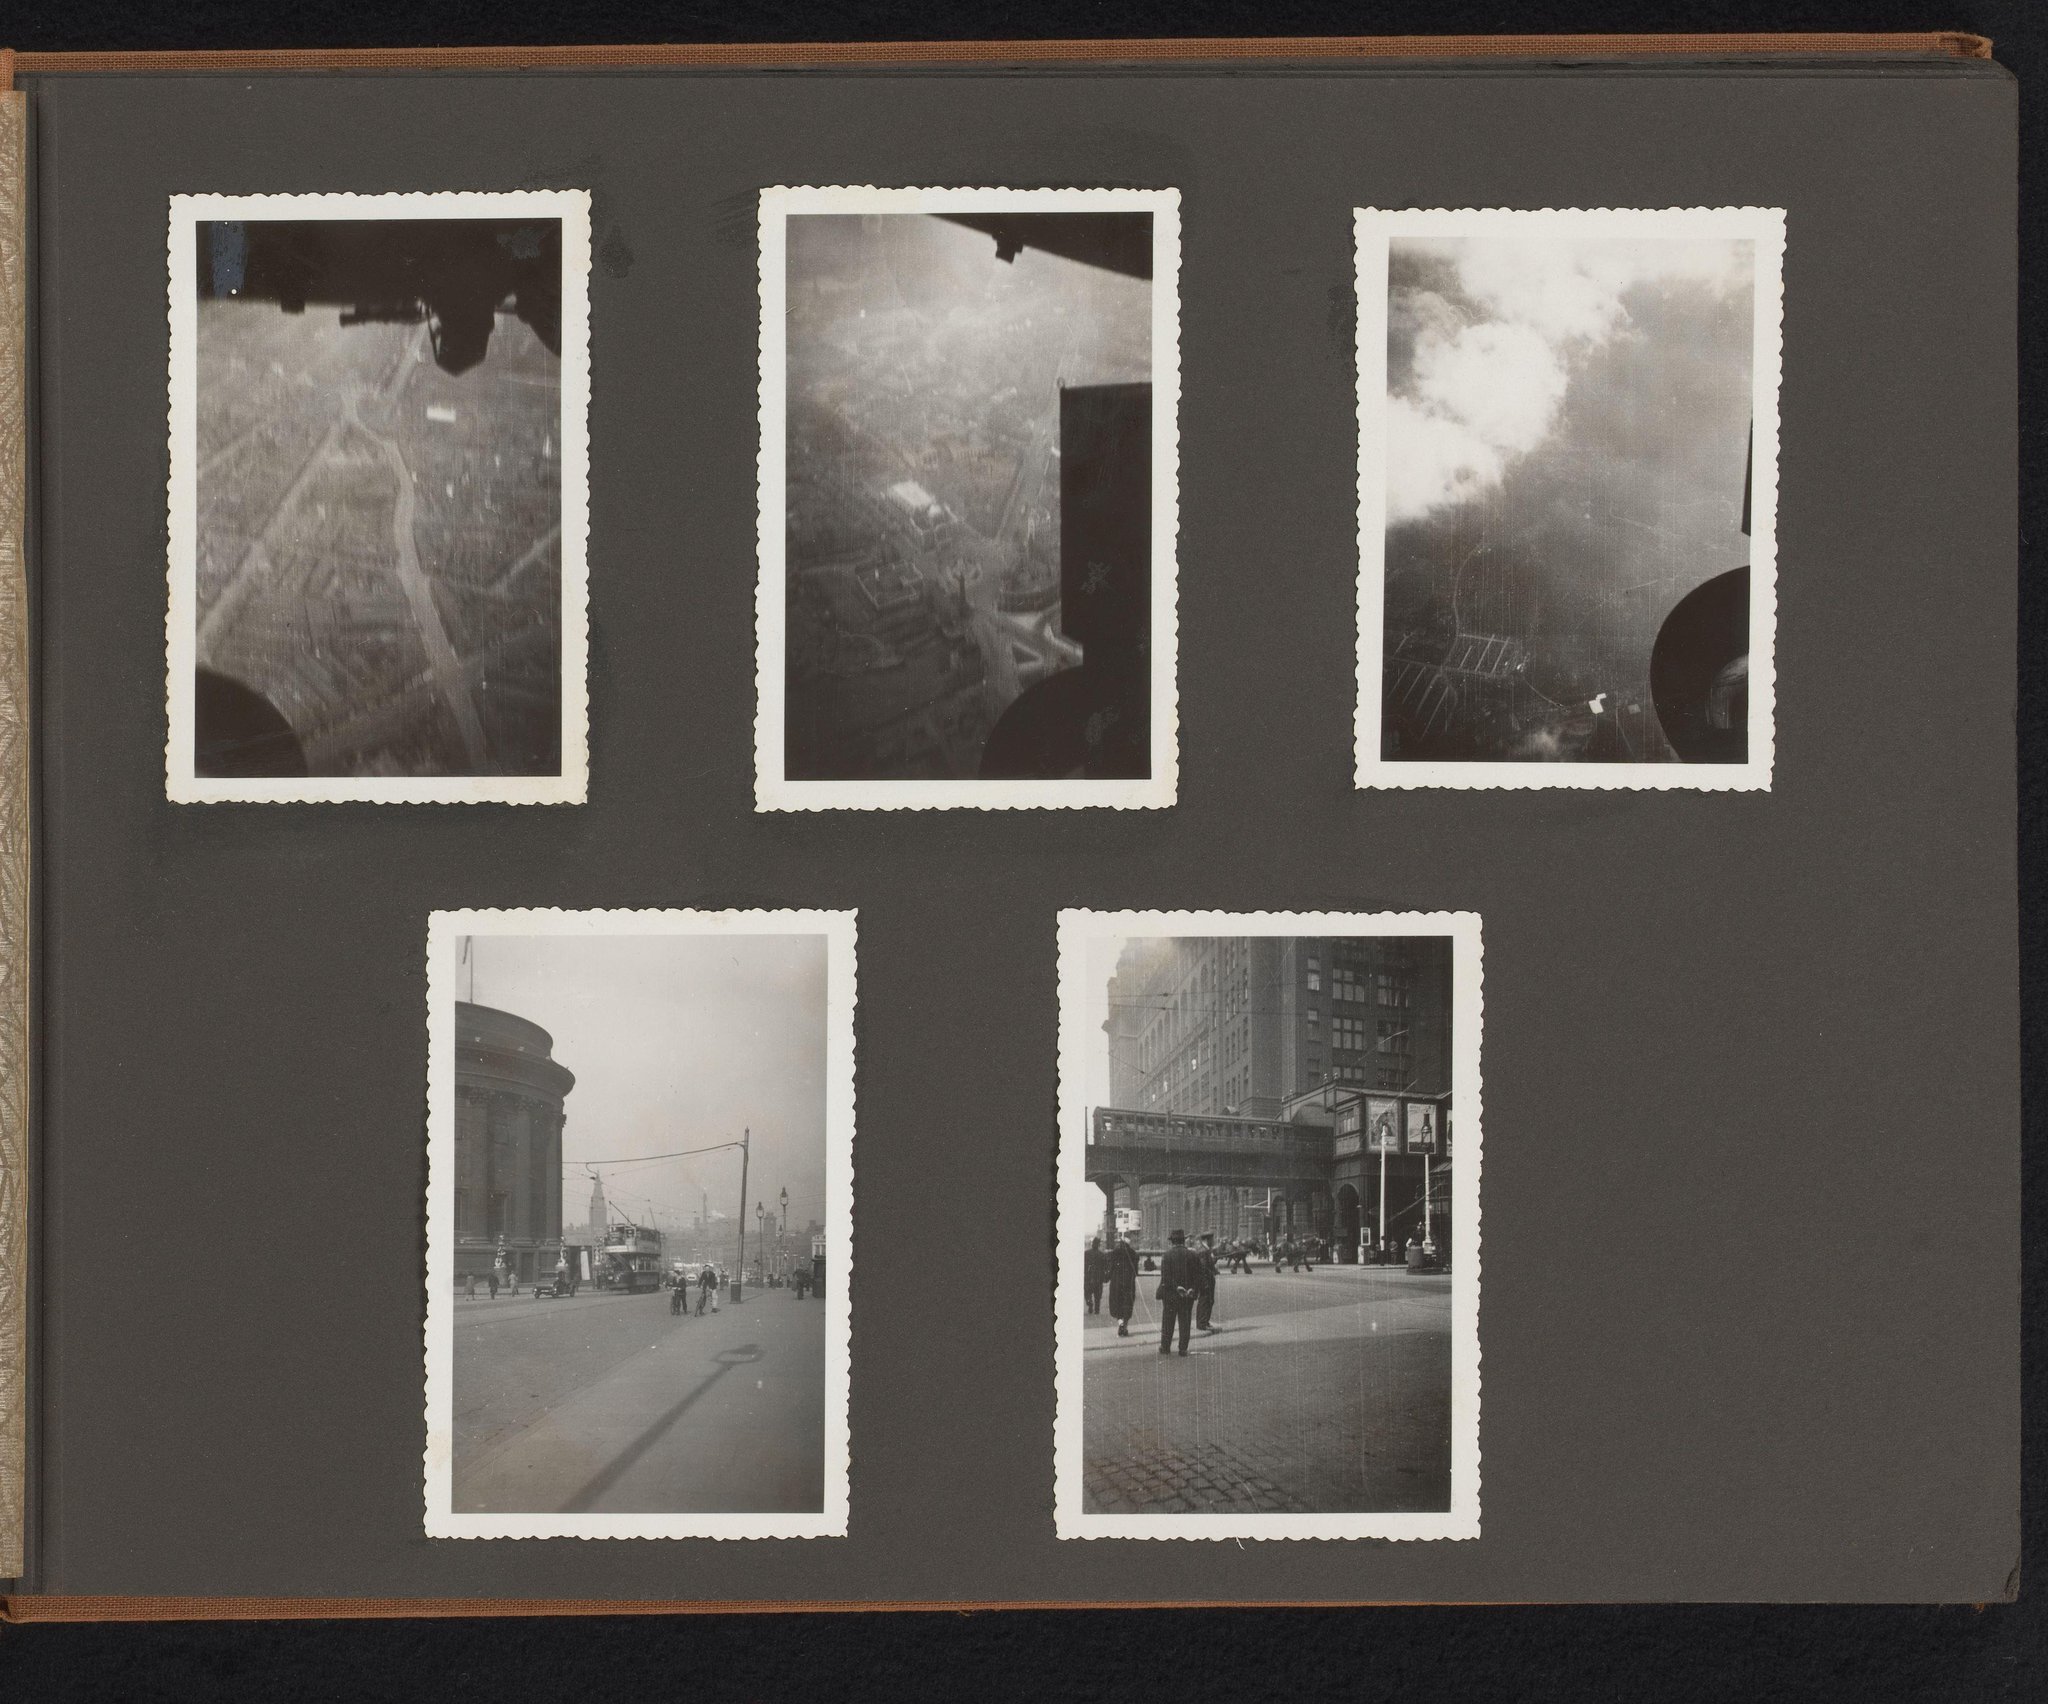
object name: photograph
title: Echtpaar Berti Hoppe en Herman Besselaar op vakantie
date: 1936-1939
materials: cardboard, paper, photographic support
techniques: gelatin silver print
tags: city-view in general; 'veduta', street (+ city(-scape) with figures, staffage)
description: Drie luchtfoto's en twee straatgezichten, genomen tijdens een vakantie van Berti Hoppe en Herman Besselaar. Deze pagina maakt deel uit van een album.